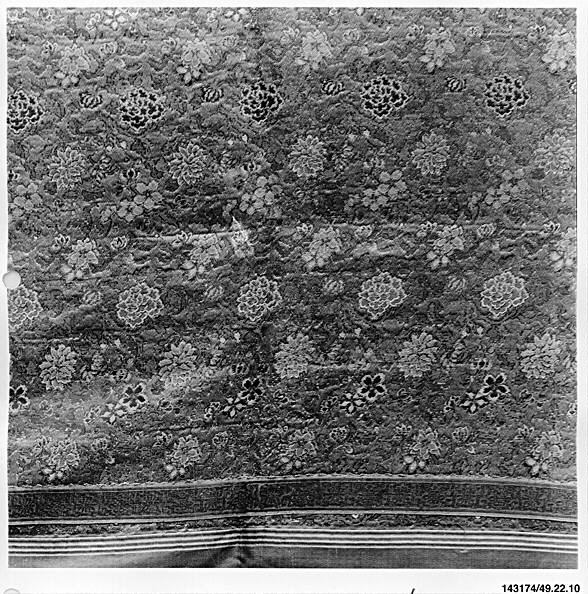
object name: piece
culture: chinese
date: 1701-1900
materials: metal thread, ribbon, silk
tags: flowers